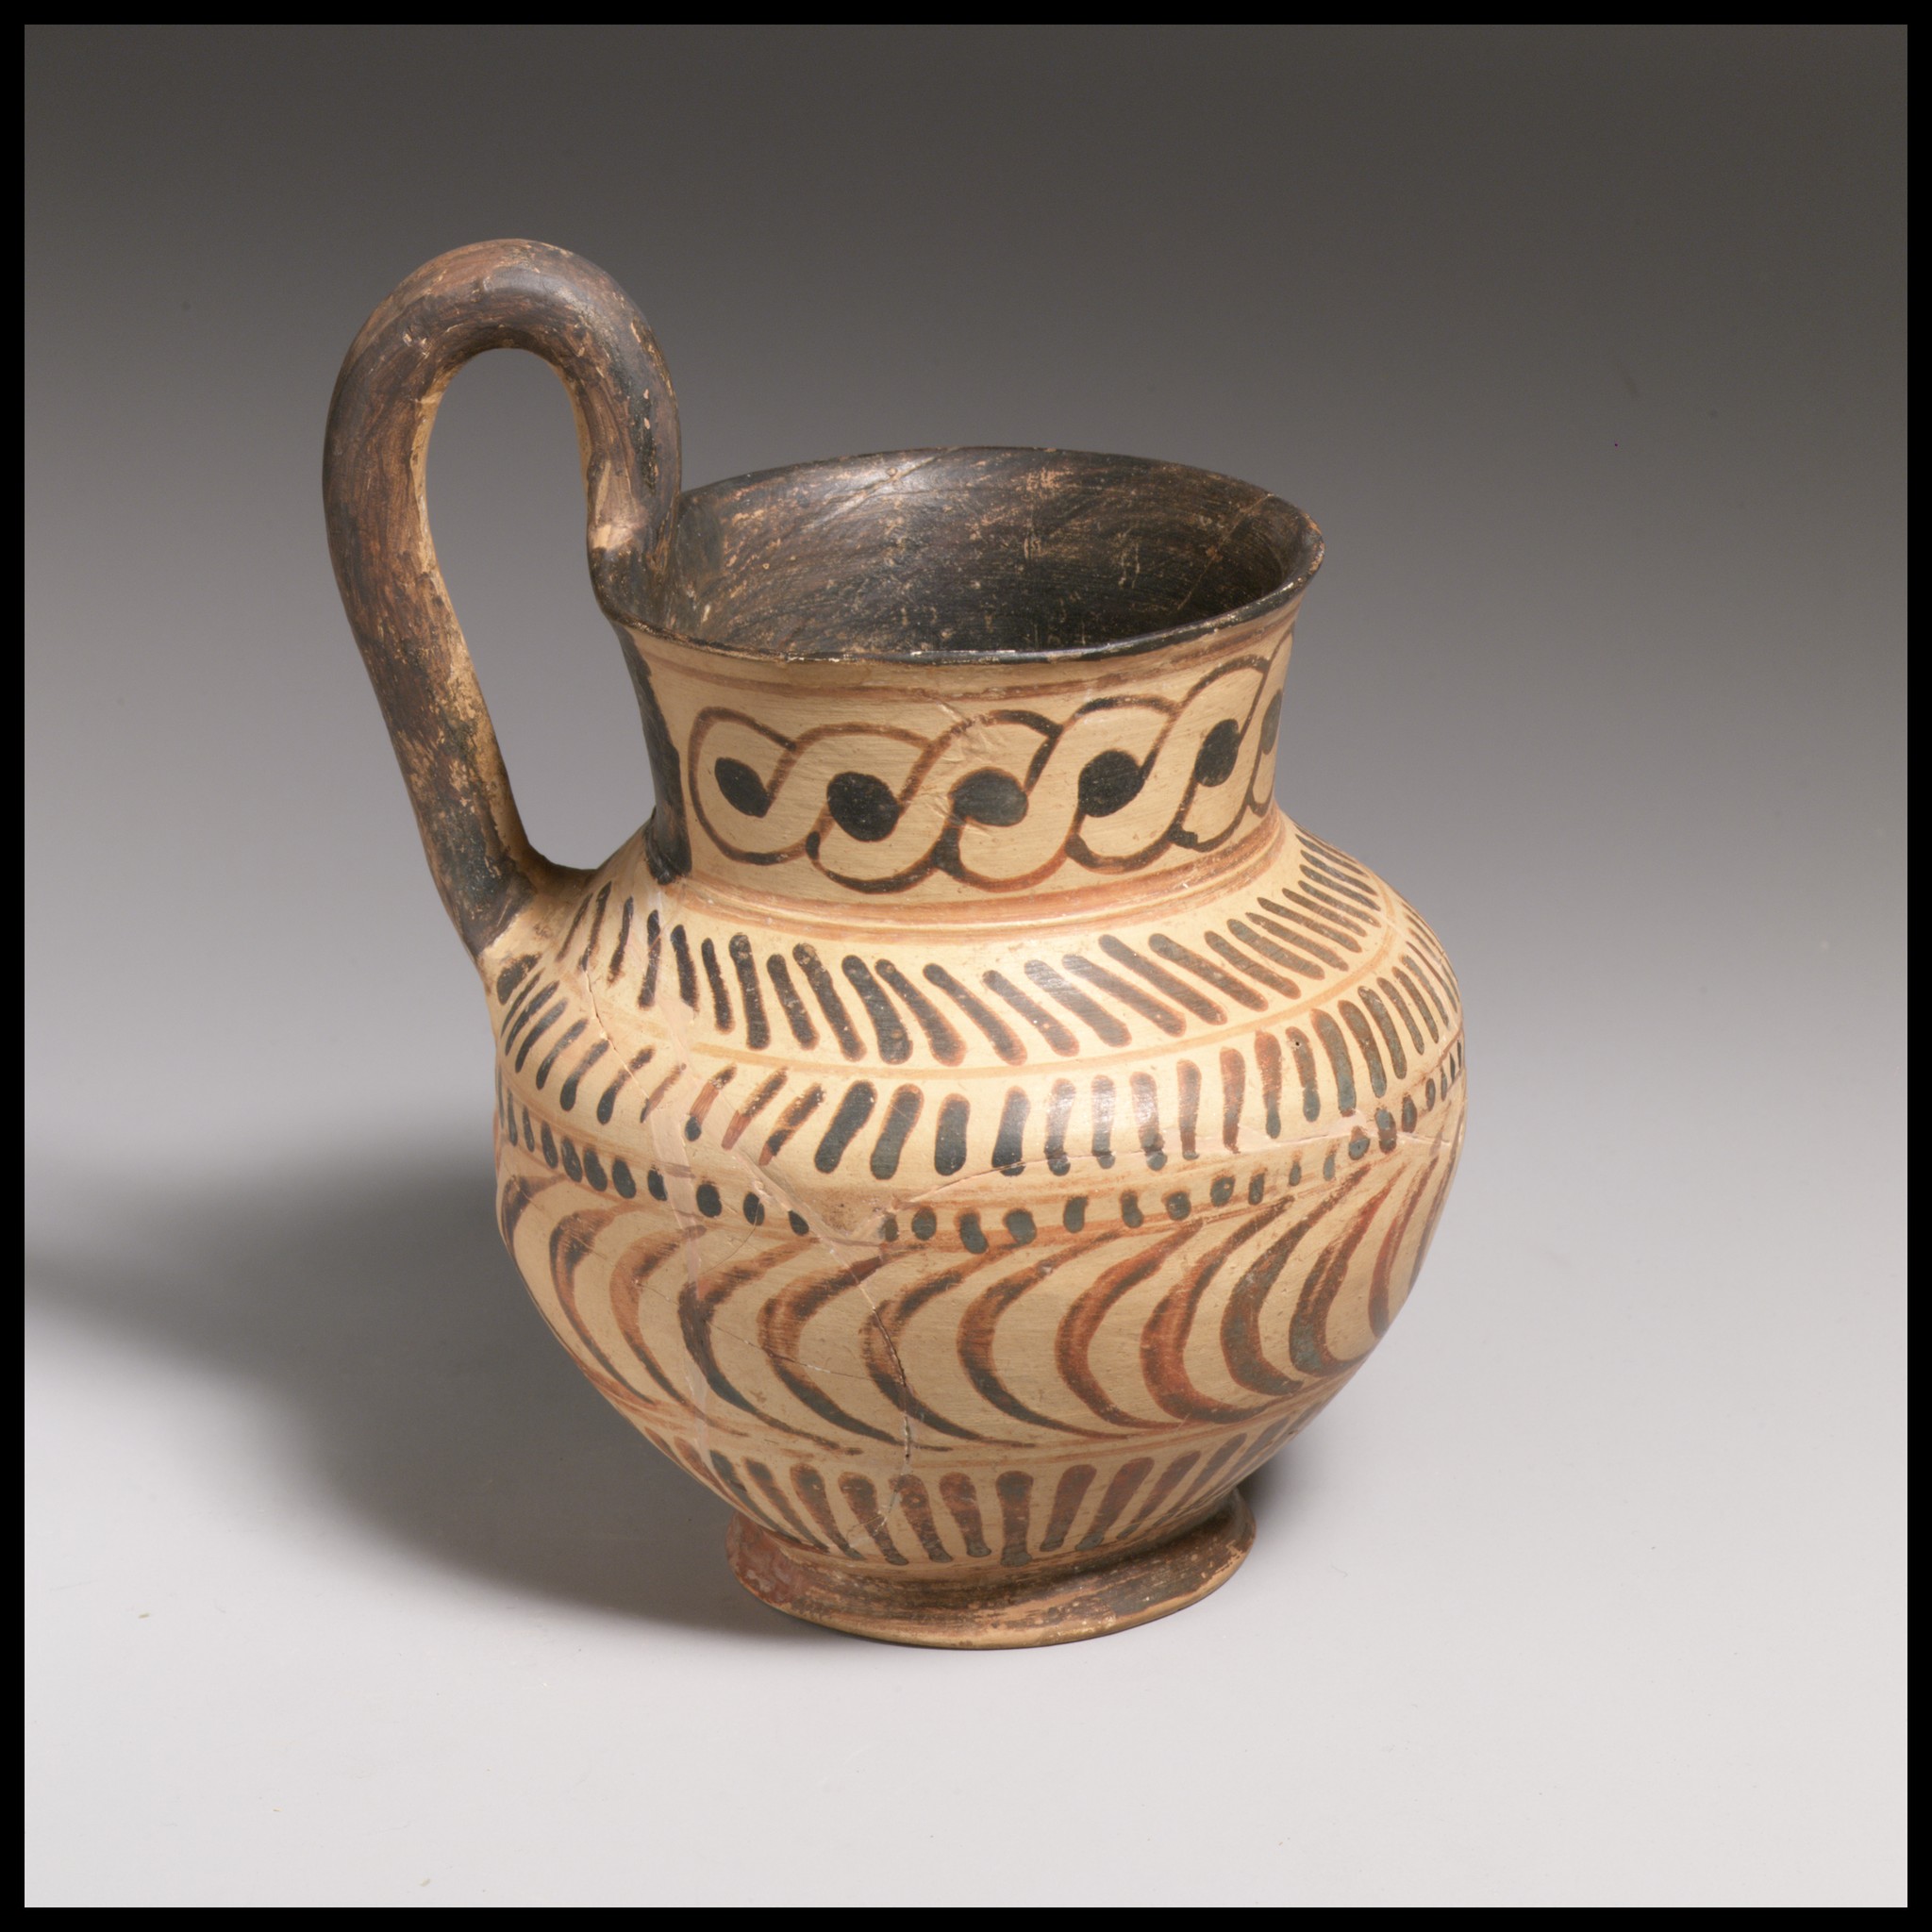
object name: oinochoe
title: Terracotta oinochoe (jug)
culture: greek, east, milesian, fikellura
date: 600-501 BCE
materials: terracotta